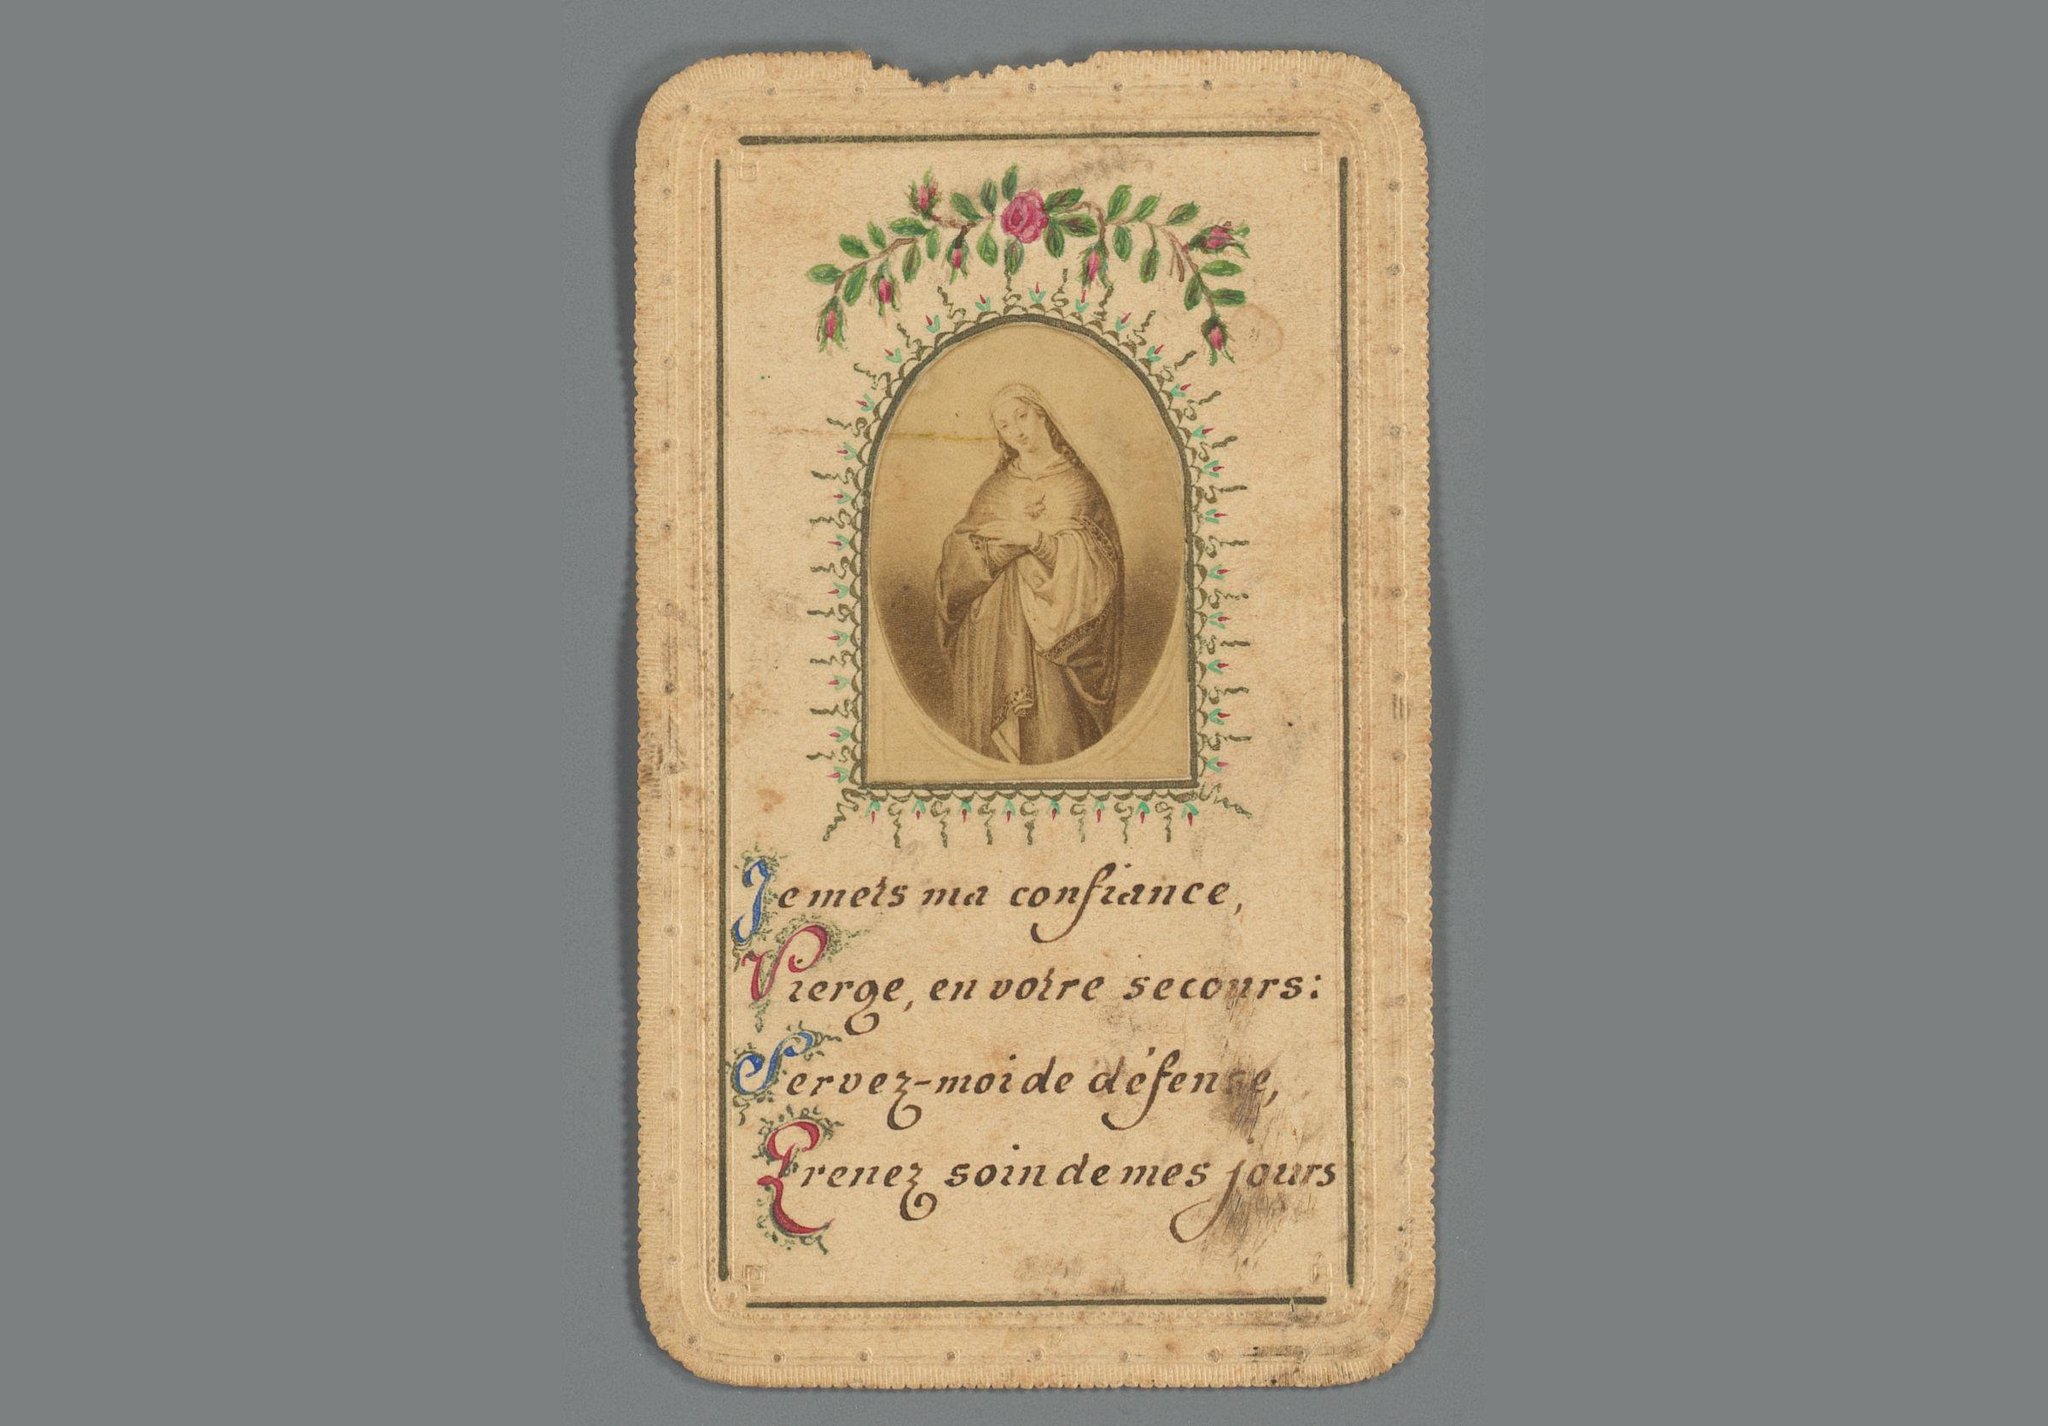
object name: reproduction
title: Fotoreproductie van een schilderij van Maria op bidprent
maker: Anonymous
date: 1879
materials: paper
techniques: albumen print, blind stamped, hand coloring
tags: picture, painting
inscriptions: inscription: ‘Souvenez-vous qu'il vaut/ bien la peine de vivre/ sans plaisir pour pouvoir/ mourier sans peine./ Ma bonne Marie un/ petit souvenir dans des/ prières réclame/ Sa devouée/ St M. Augustine/ Noah/ le 2 Juin 79/ au S Coeur de Jéans’